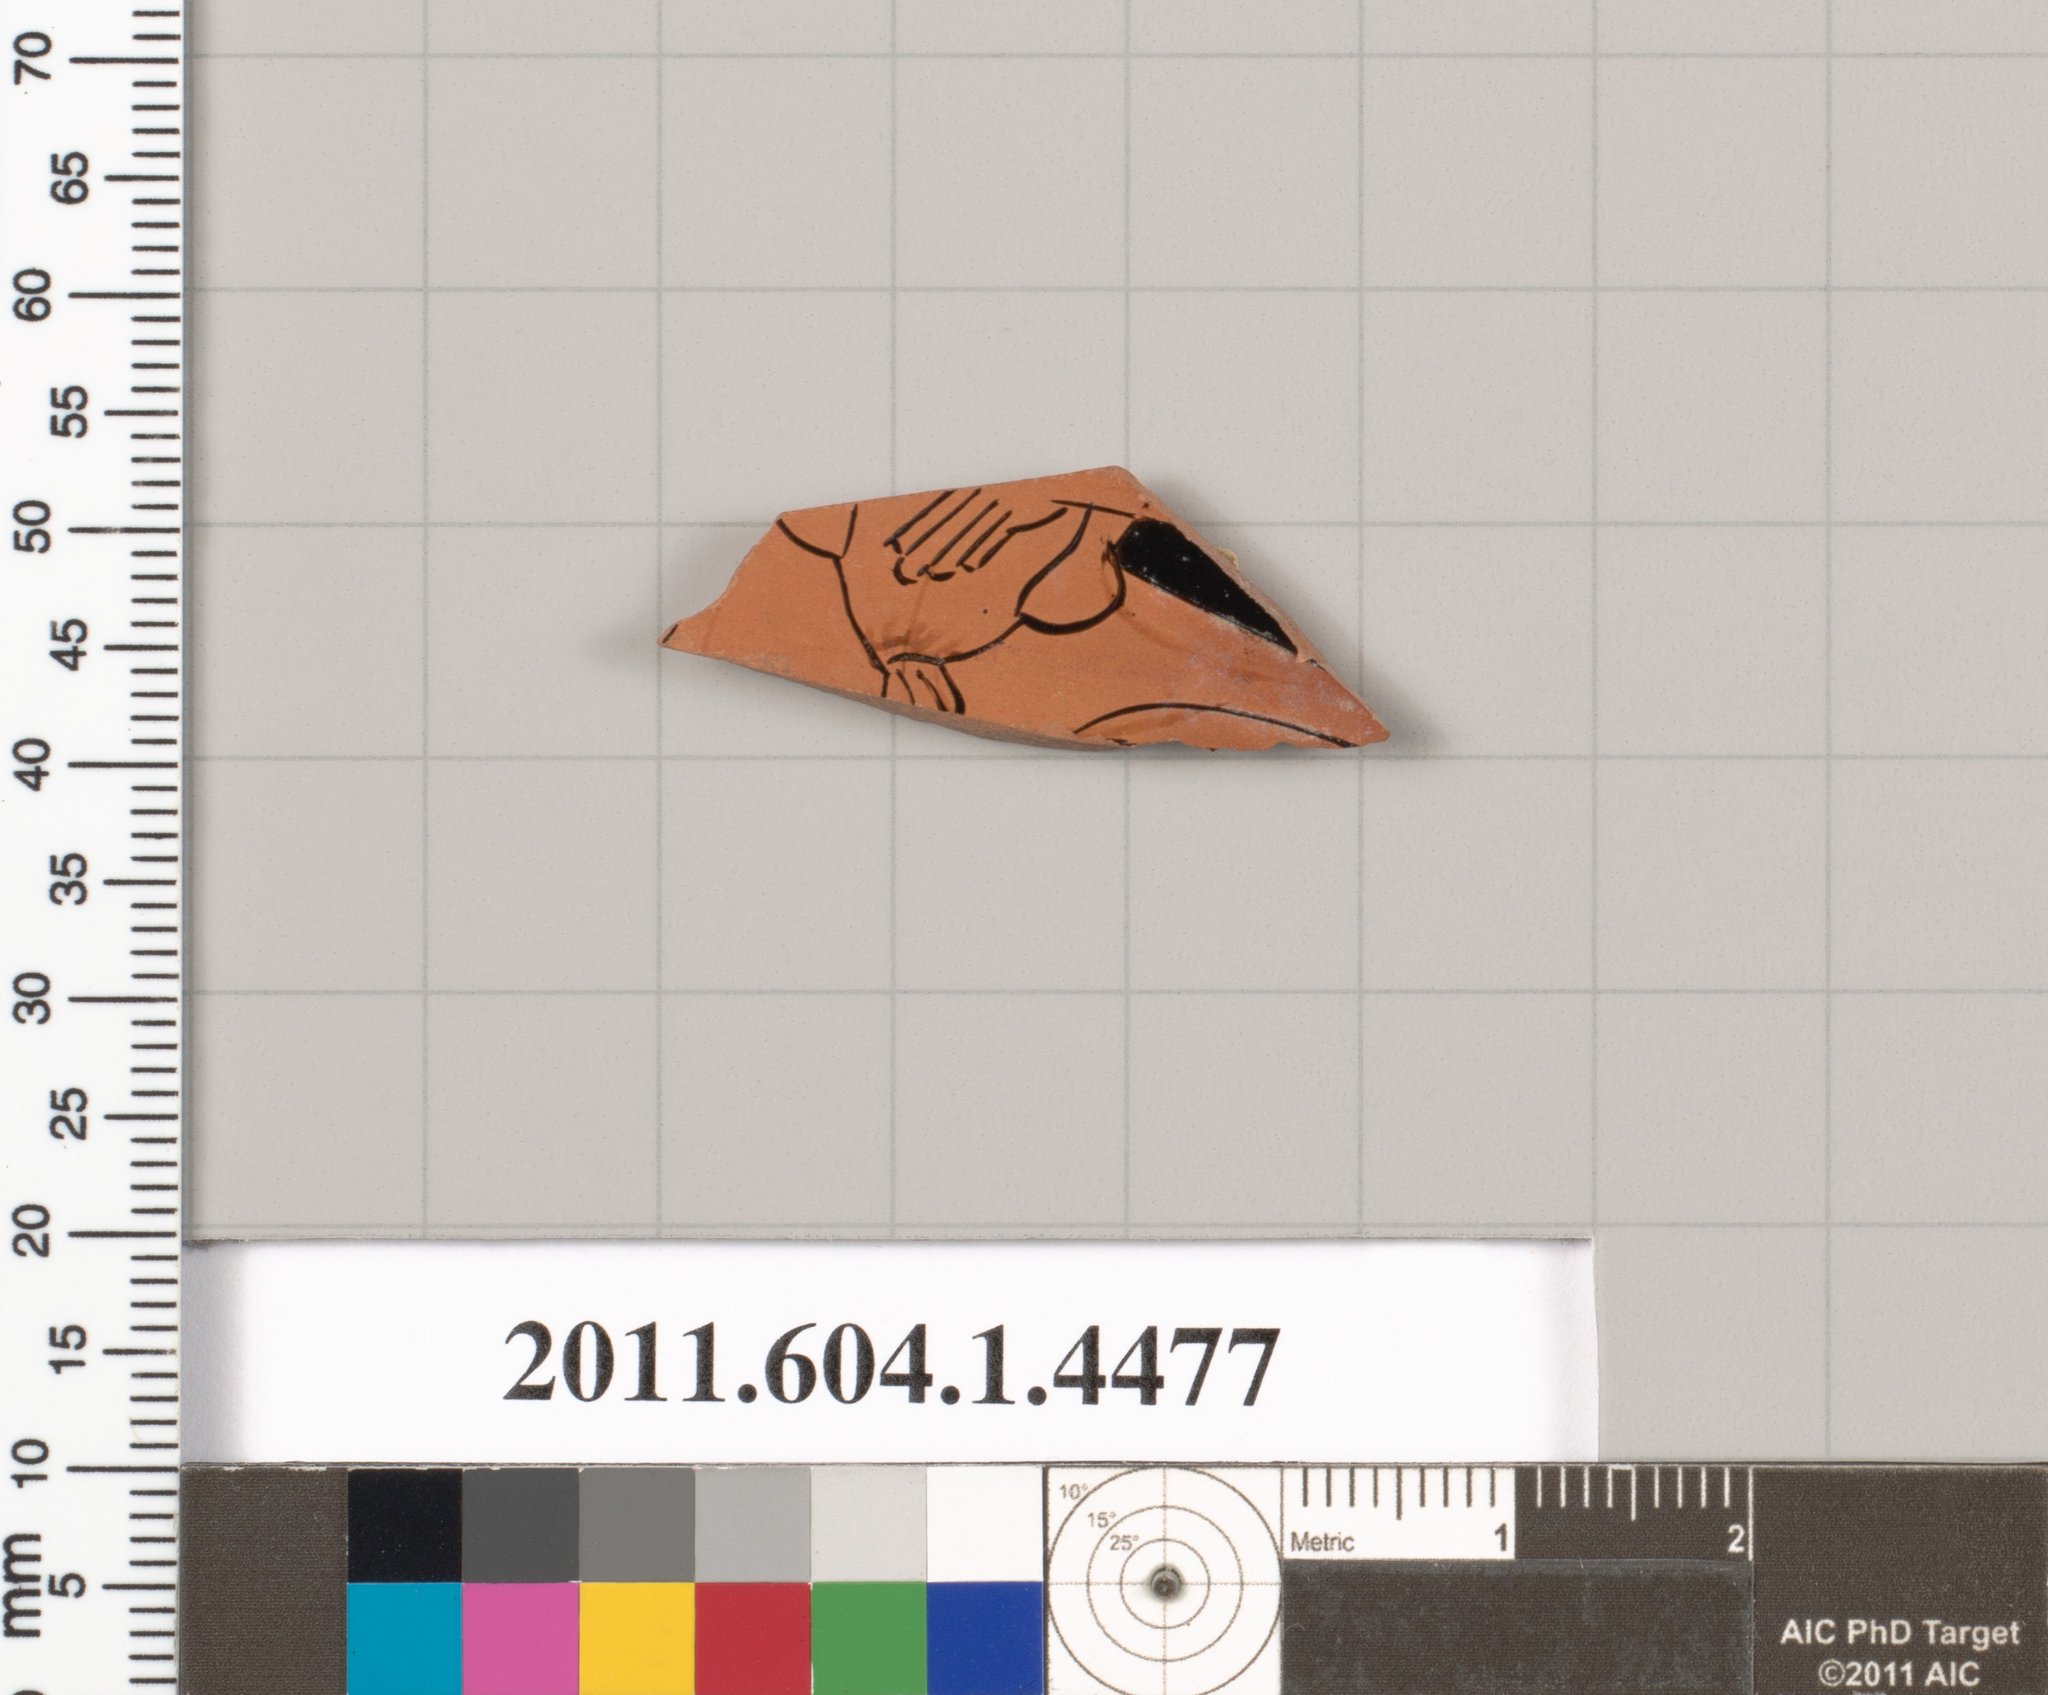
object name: kylix fragment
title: Terracotta fragment of a kylix (drinking cup)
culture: greek, attic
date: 490-470 BCE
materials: terracotta